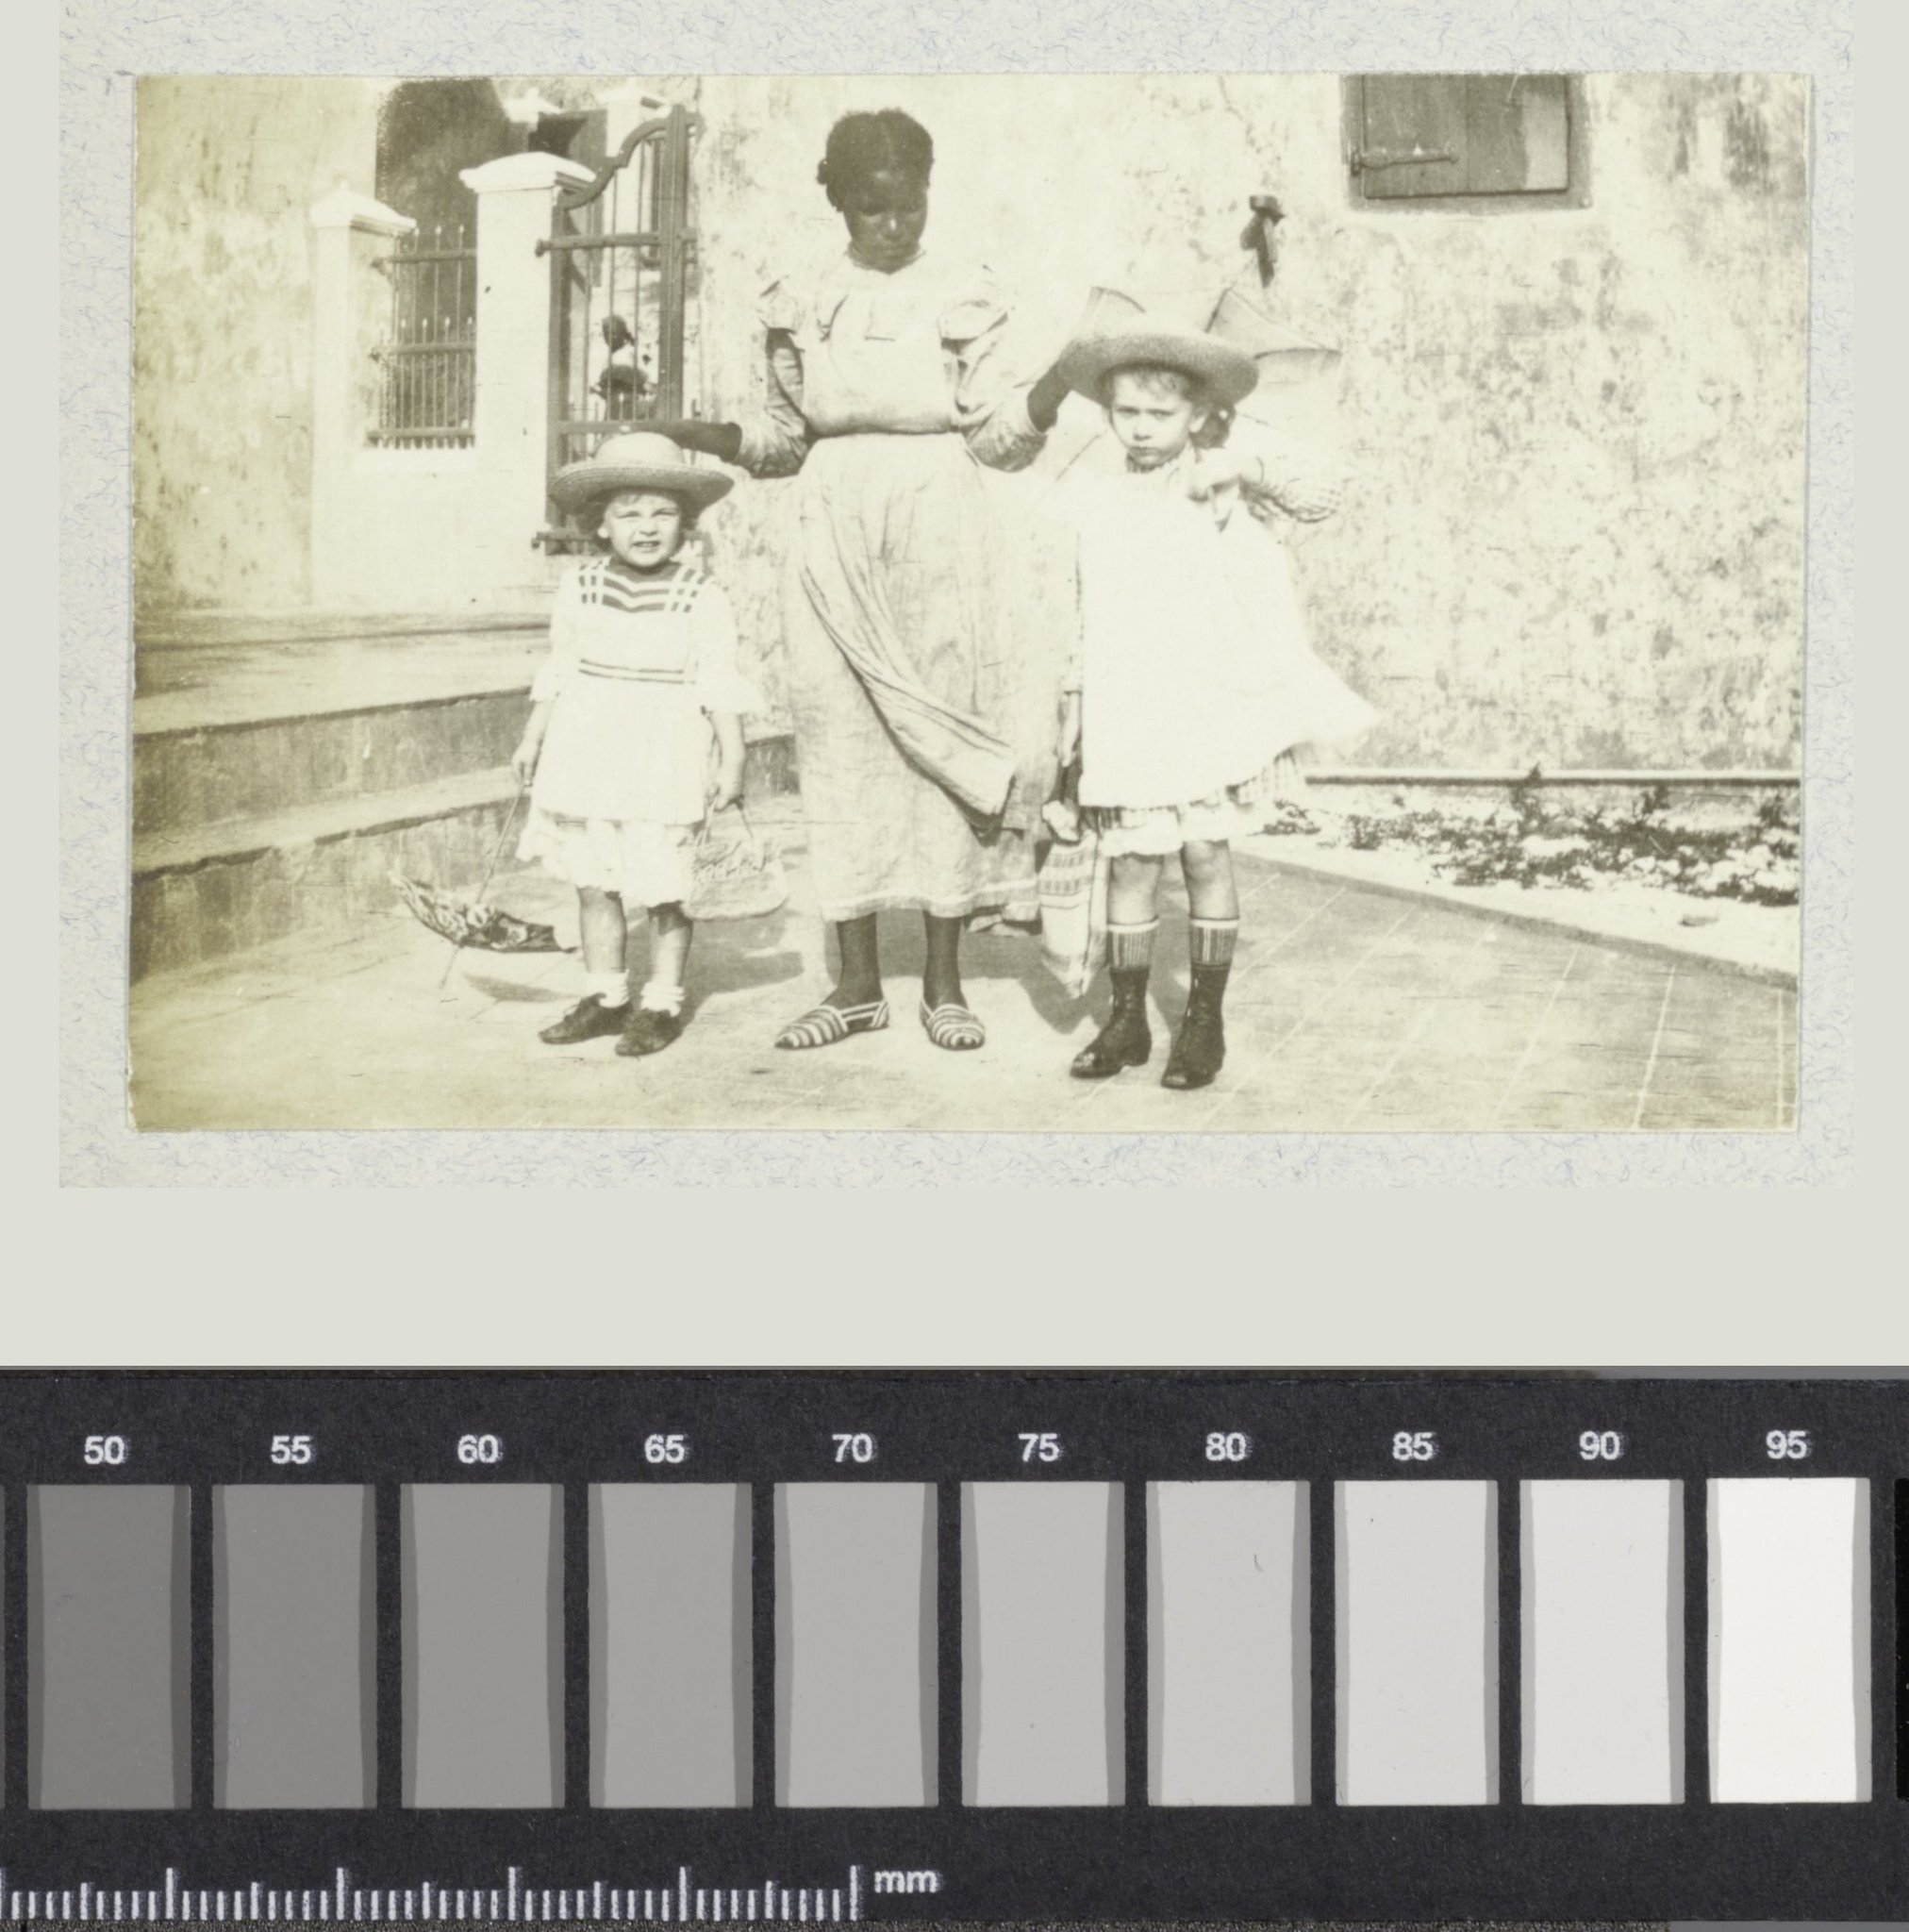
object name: photograph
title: Ernita en Maria de Vries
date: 1901-1912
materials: photographic support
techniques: photography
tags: taking care of children, maid ~ house personnel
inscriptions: inscription: ‘Ernita en Maria de Vries. / Jan. 1912. Curaçao’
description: Portret van de twee kleine zusjes Ernita en Maria de Vries samen met een kindermeisje, op Curaçao, januari 1912. Onderdeel van het fotoalbum van de familie Boom-Gonggrijp in Suriname en Curaçao.